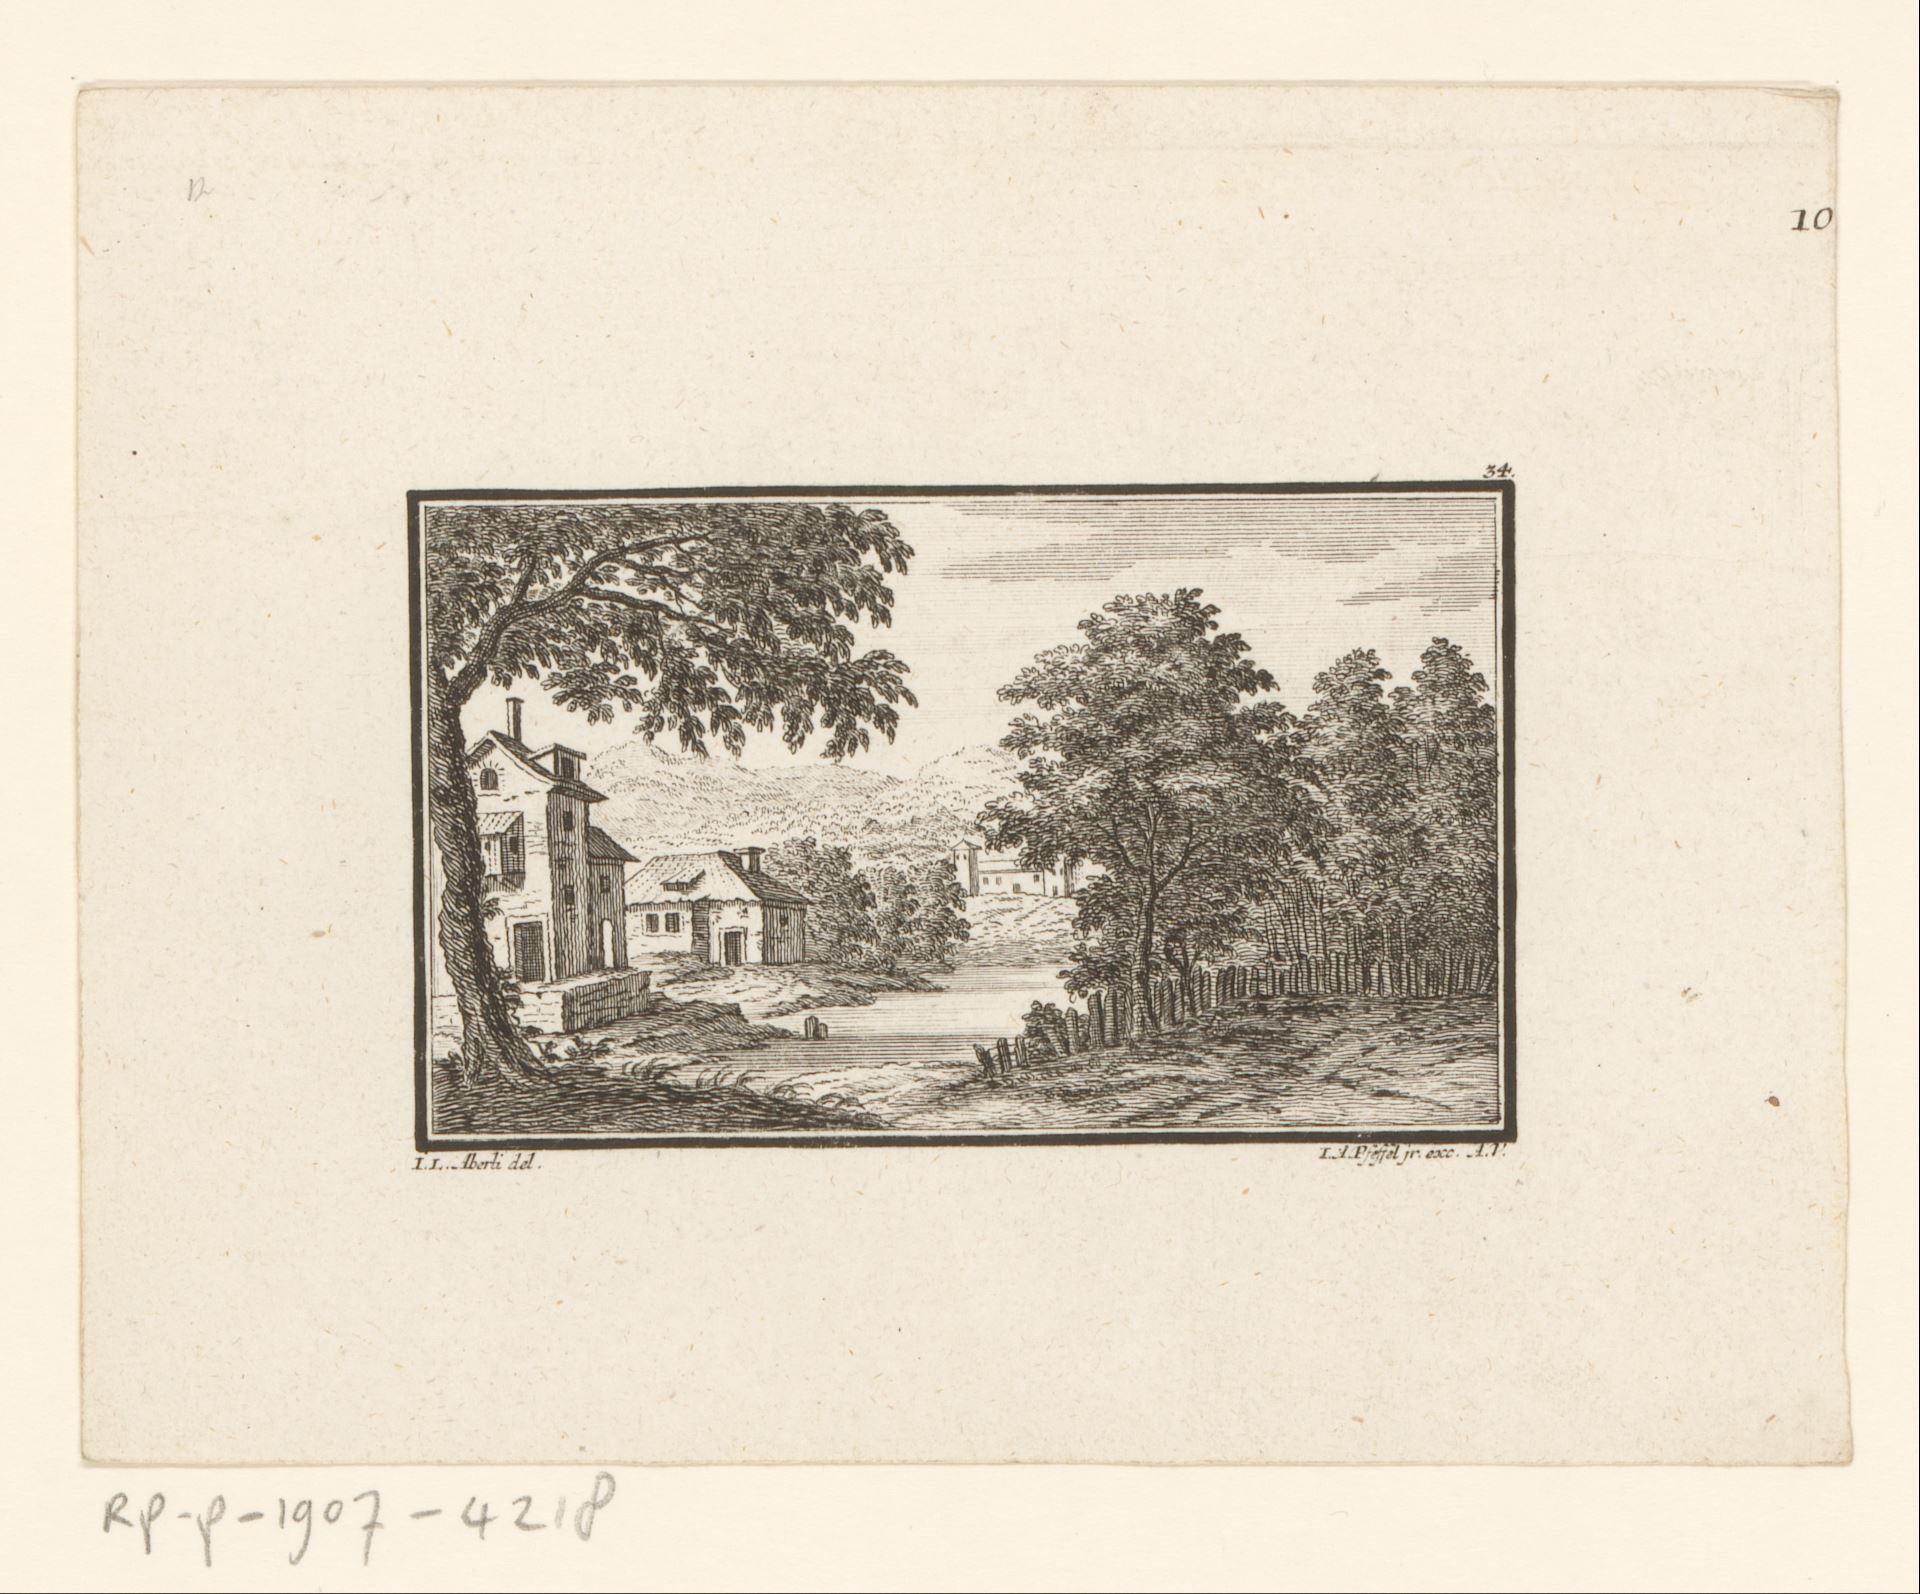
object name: print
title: Gezicht op een landhuis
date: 1725-1768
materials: paper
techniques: etching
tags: city-view, and landscape with man-made constructions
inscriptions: collector's mark: Lugt 2228